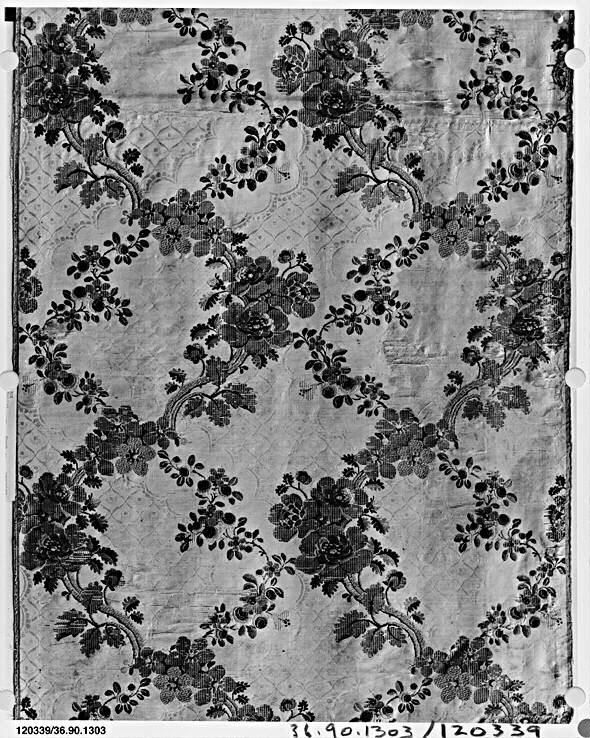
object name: piece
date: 1750-1760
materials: metal thread, silk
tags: flowers,leaves